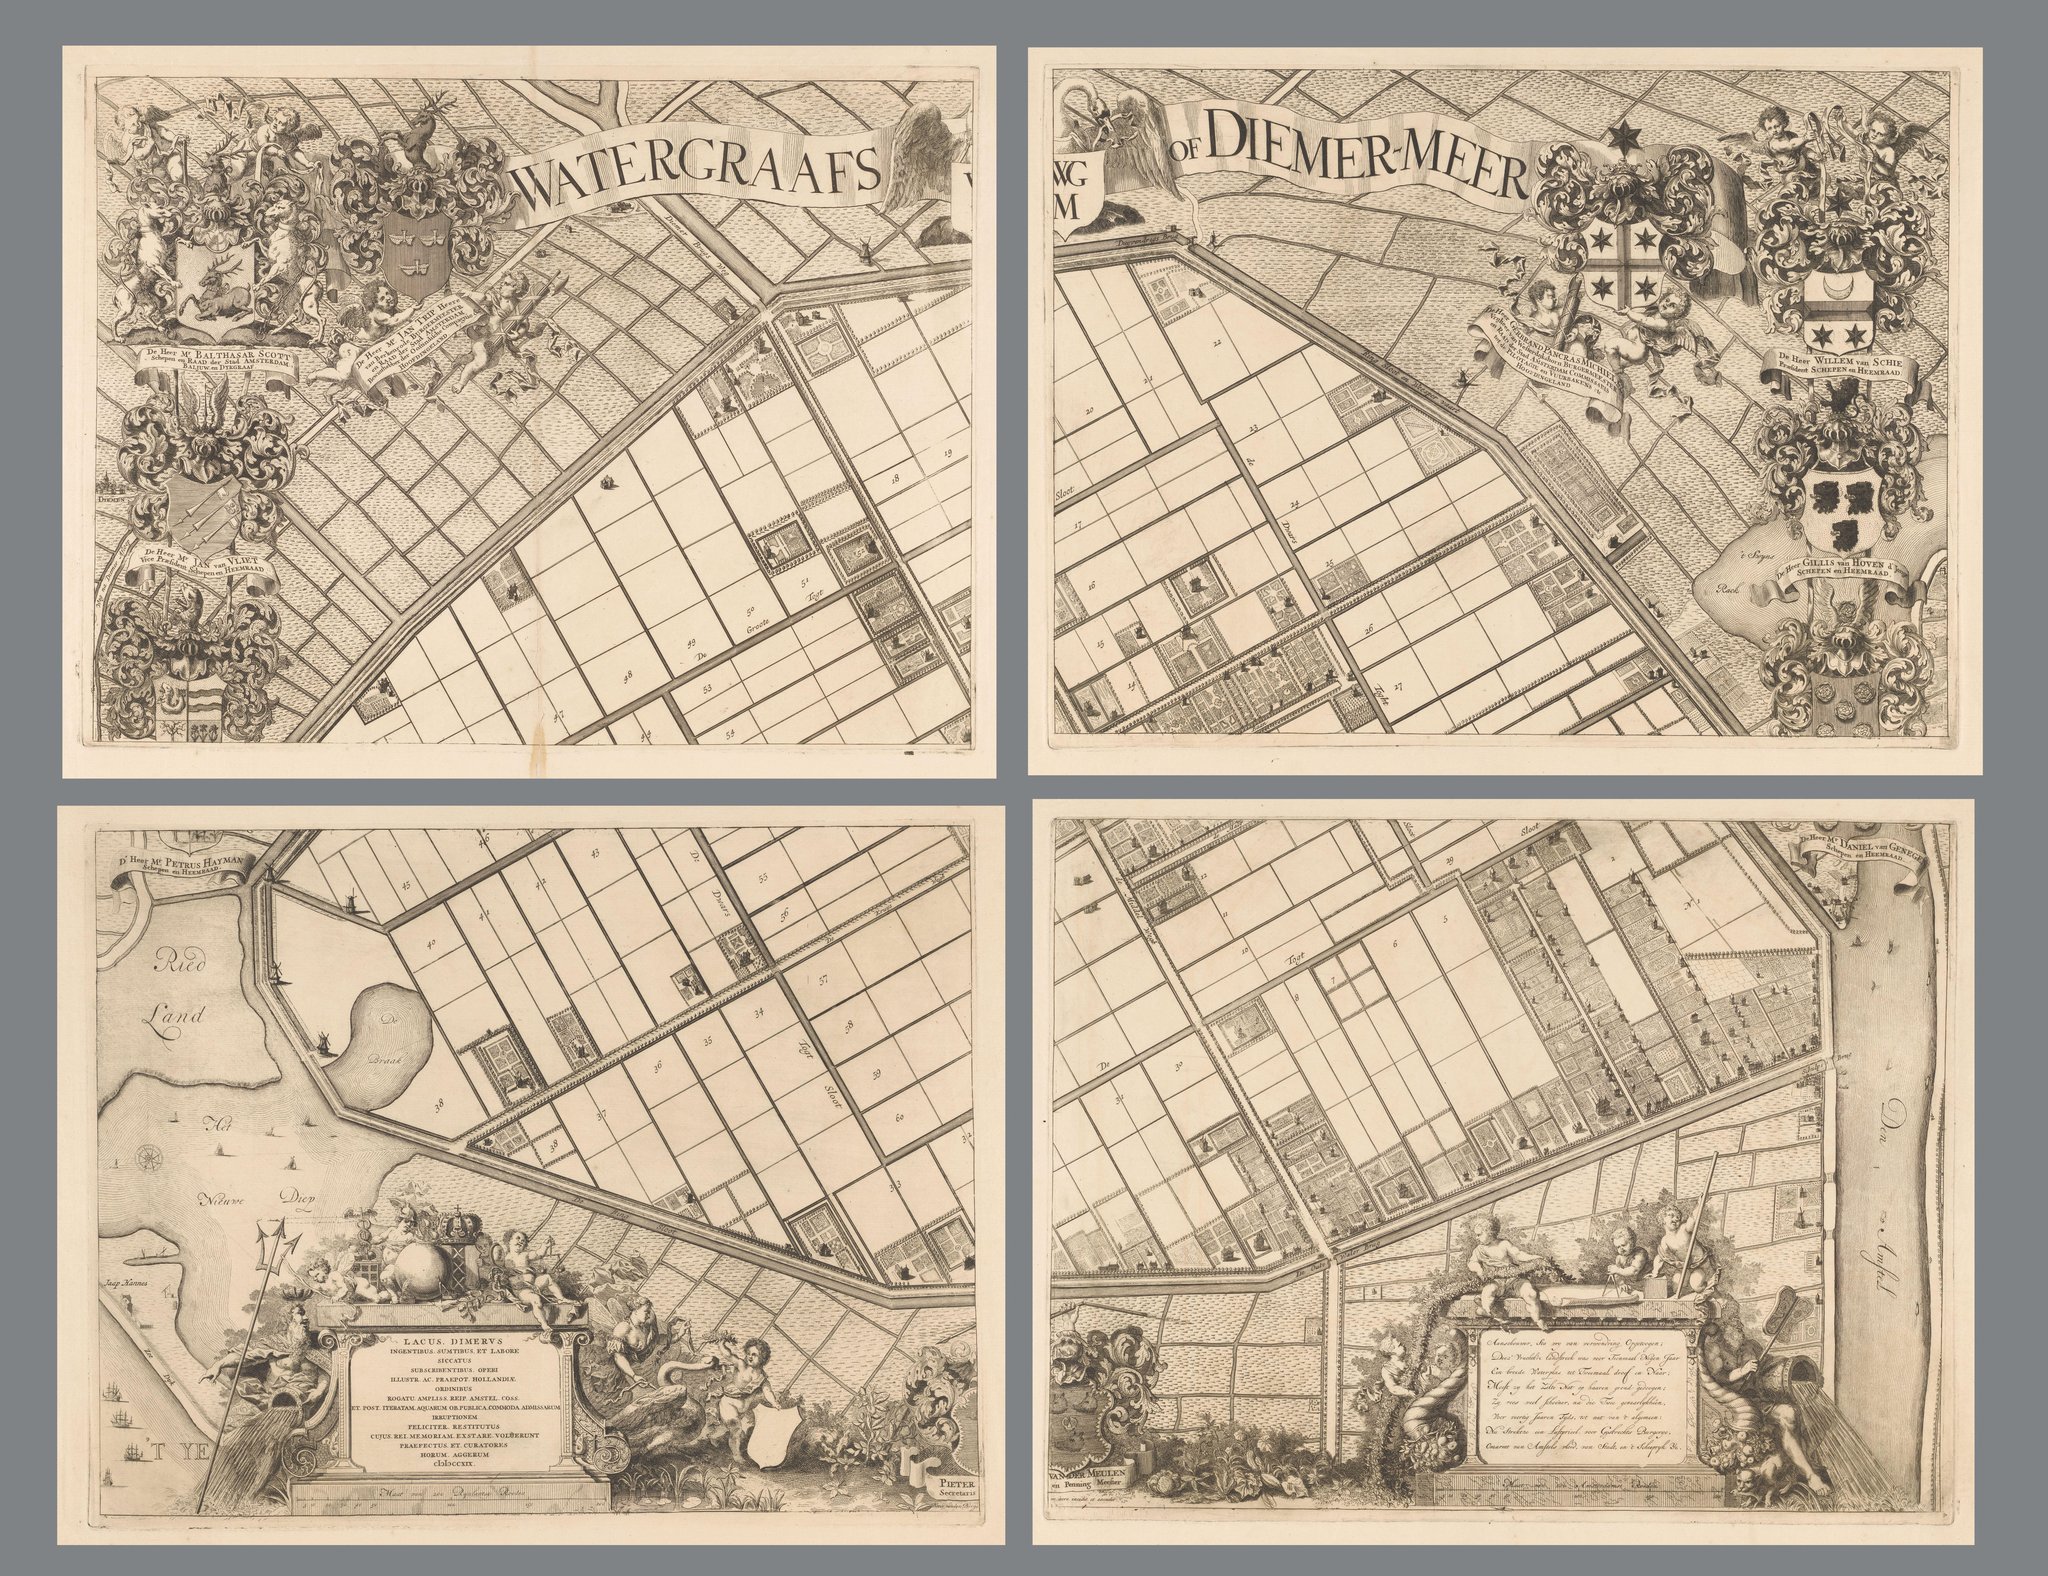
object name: print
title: Watergraafs of Diemer-meer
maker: pieter van den berge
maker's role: draughtsman, print maker, printer, publisher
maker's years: 1659-1737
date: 1719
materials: paper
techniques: engraving, etching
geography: amsterdam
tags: (story of) neptune (poseidon), coat of arms (as symbol of the state, etc.) (+ city; municipal), maps of separate countries or regions, water-birds: swan, river-gods, polder, reclaimed land, armorial bearing, heraldry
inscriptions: collector's mark: Lugt 2228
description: Langs de bovenkant de titel en het wapen van het hoogheemraadschap van de Watergraafsmeer. Linksboven de wapens van een hoofdingeland, de dijkgraaf en twee heemraden. Rechtsboven de wapens van een hoofdingeland en drie heemraden. Linksonder een cartouche met een Latijnse tekst en een schaalstok: Maat van 200 Rynlantse roeden. Daaromheen Neptunus of een riviergod, putti met verschillende attributen die onder andere verwijzen naar de handel, het wapen van Amsterdam en een vrouwfiguur met een zwaan. Onder in het midden het wapen van de secretaris en penningmeester. Rechtsonder een cartouche met een Nederlands gedicht over de Watergraafsmeer en een schaalstok: Maat van 200 Amsterdamse roeden. Daaromheen putti en een riviergod.